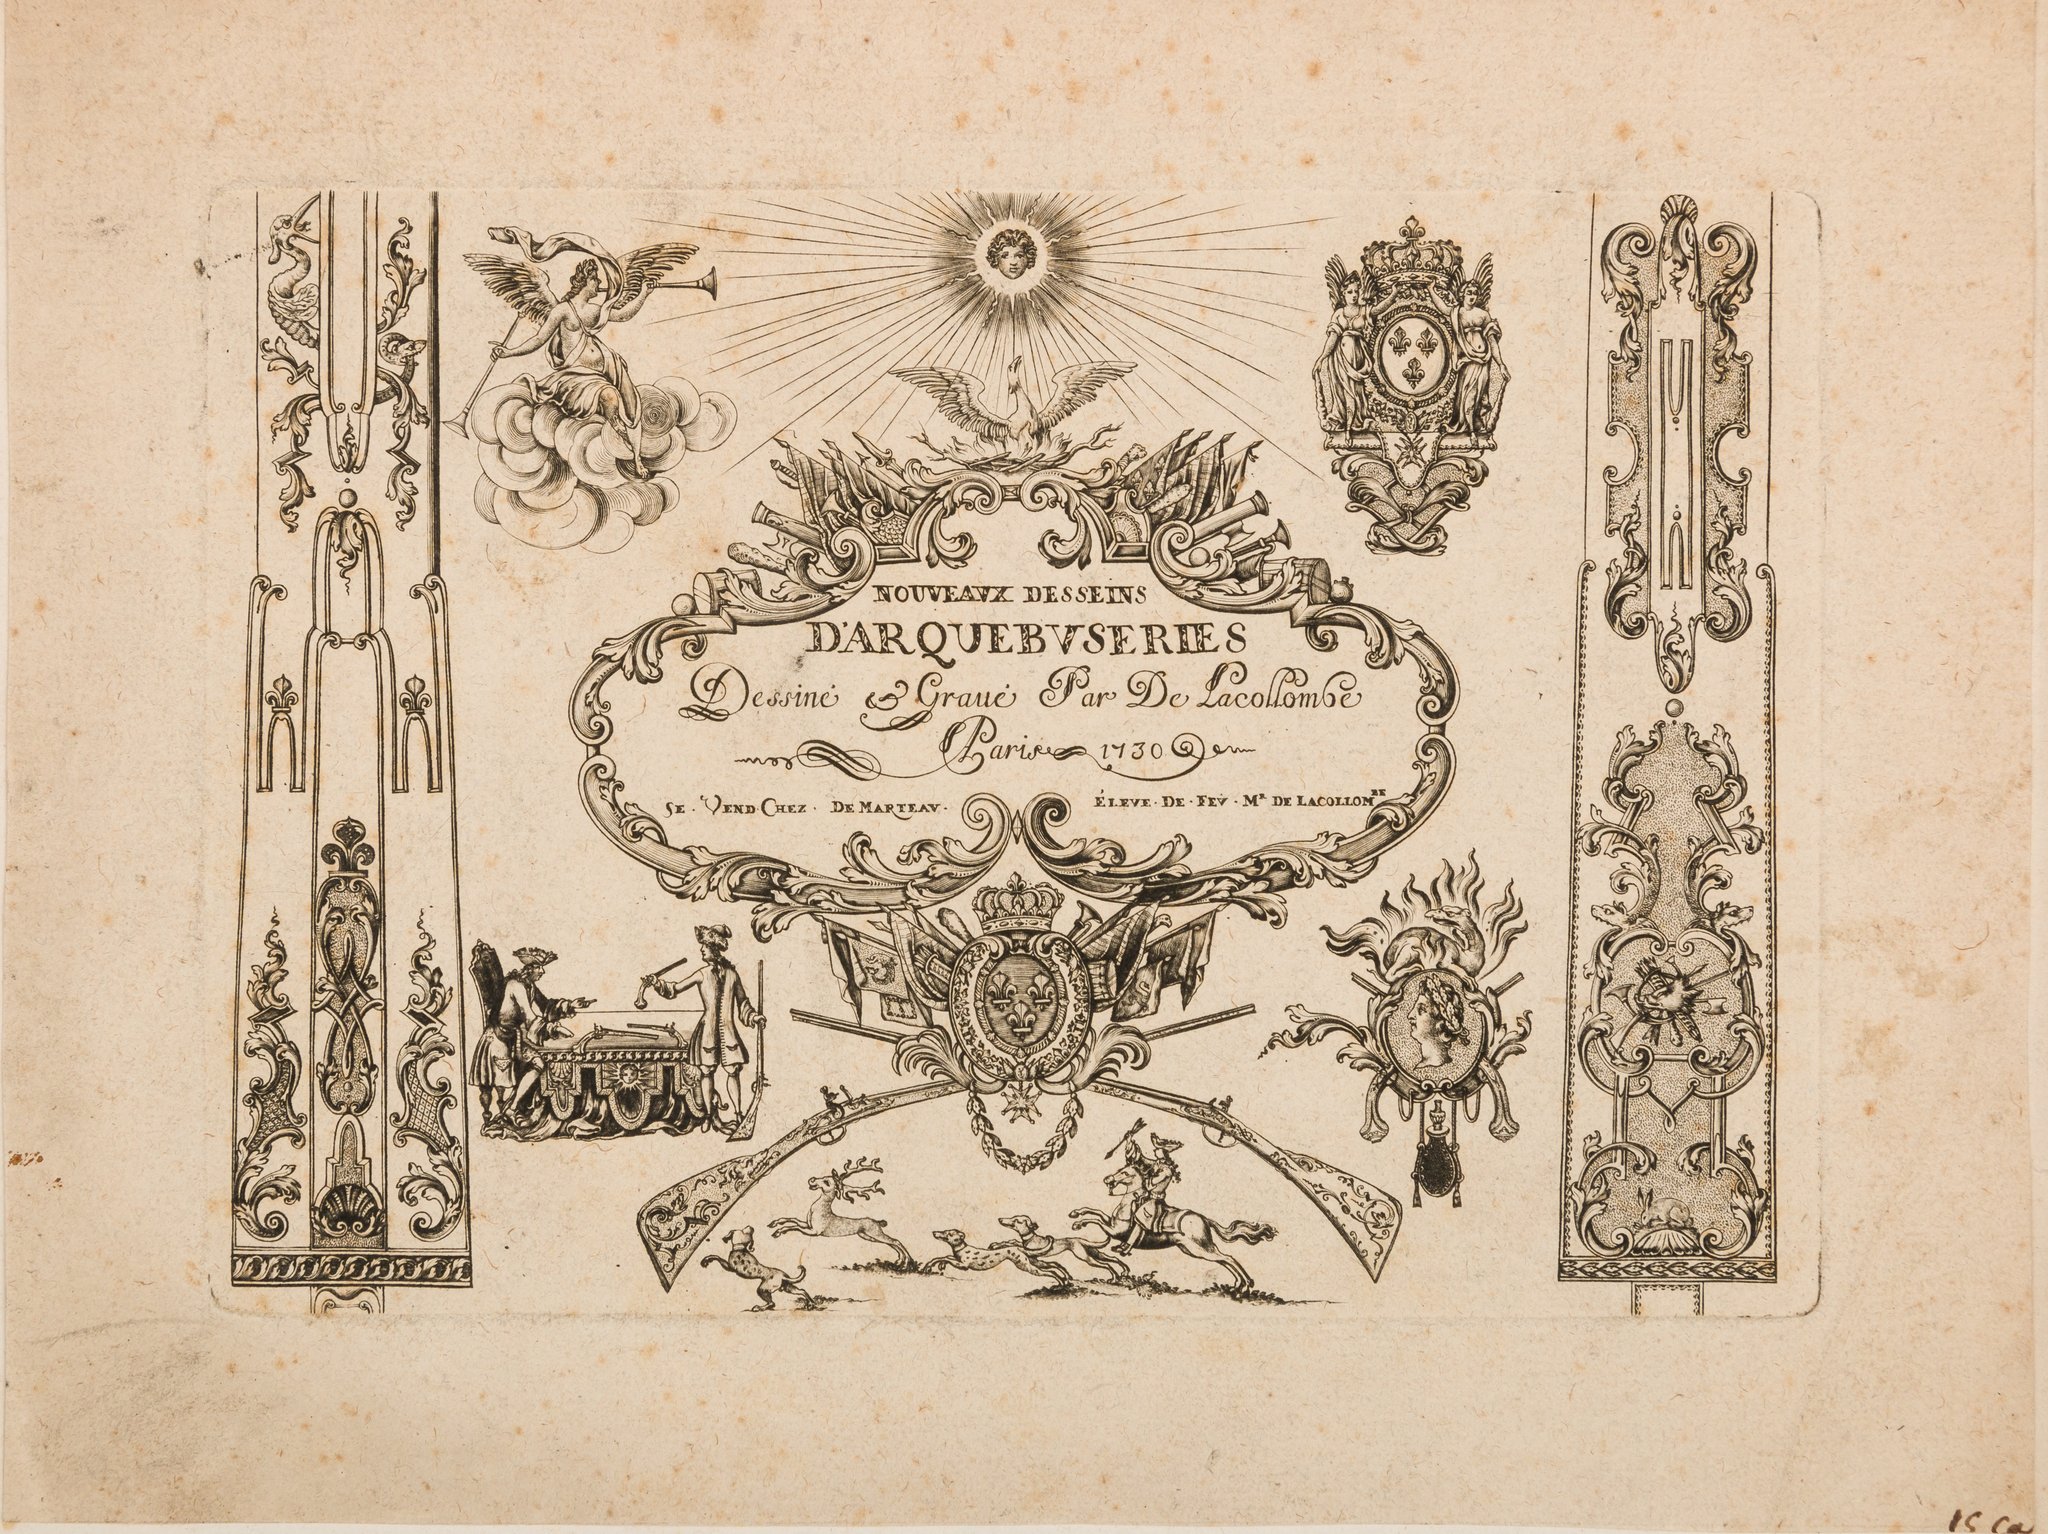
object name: engraving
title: Plate One (Title Page) from Nouveavx Desseins D'Arquebvseries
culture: french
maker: de lacollombe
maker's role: engraver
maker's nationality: french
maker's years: 1702-1736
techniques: engraving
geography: france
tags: firearms,ornament